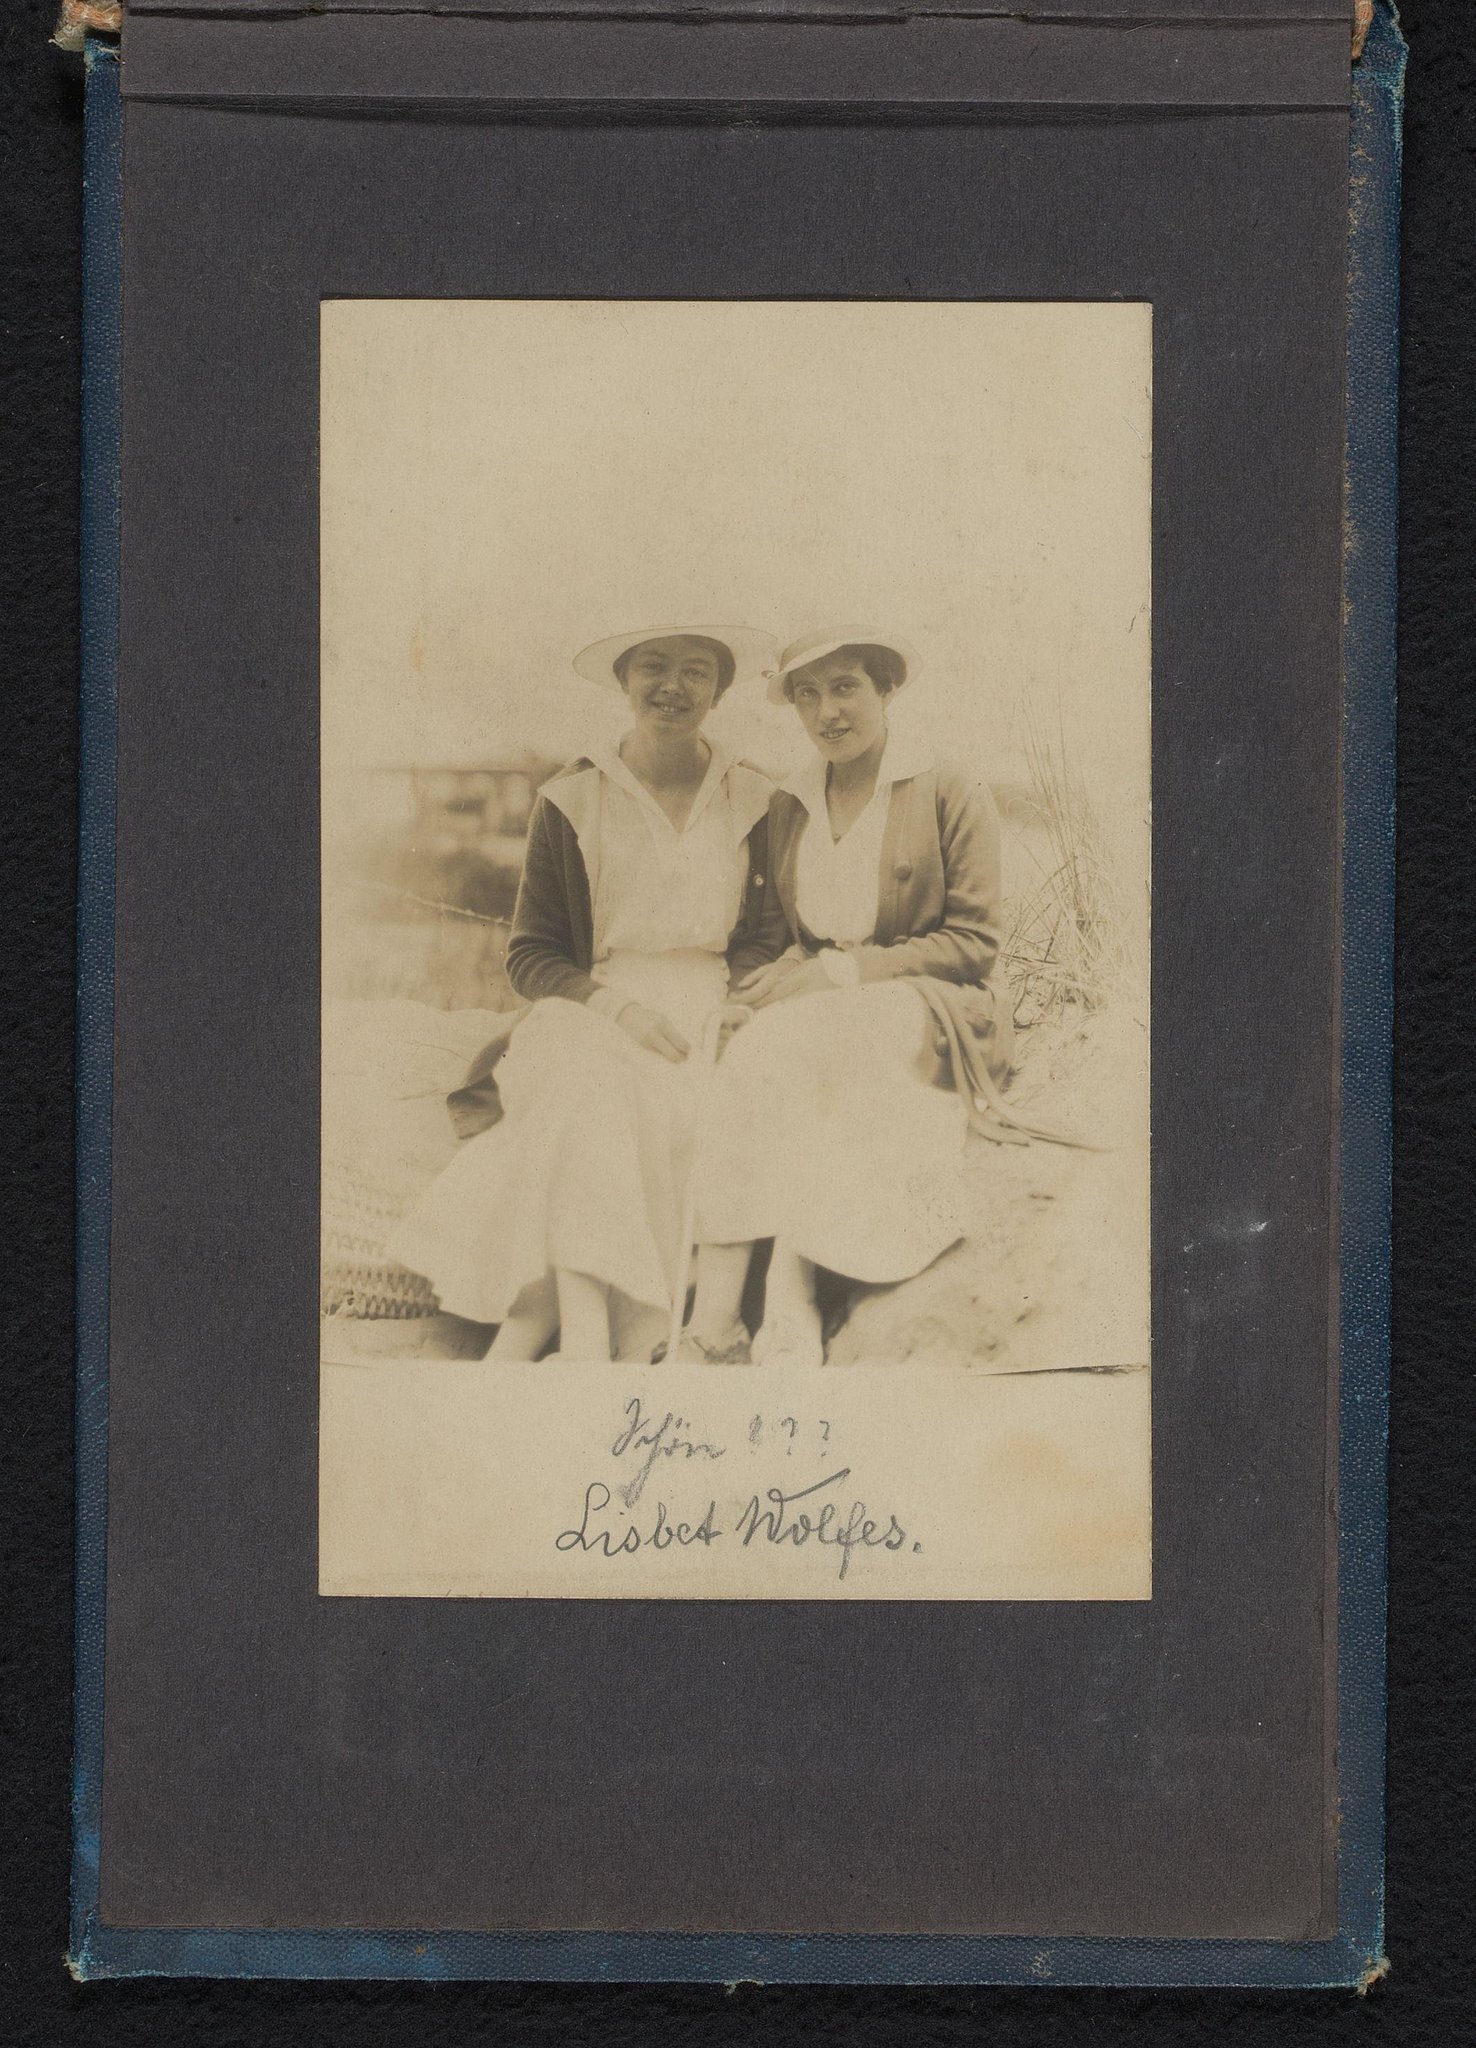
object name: photograph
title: Vriendinnen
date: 1916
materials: paper, photographic support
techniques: gelatin silver print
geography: germany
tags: else wachenheimer-moos, historical persons - bb - woman, germany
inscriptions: inscription: ‘... ??? / Lisbet Wolfes’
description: Albumblad met een foto van twee vriendinnen van Else. Onderdeel van het fotoalbum van Else Wachenheimer-Moos en haar broers Arthur en Willy Moos en anderen in de periode 1913-1918.